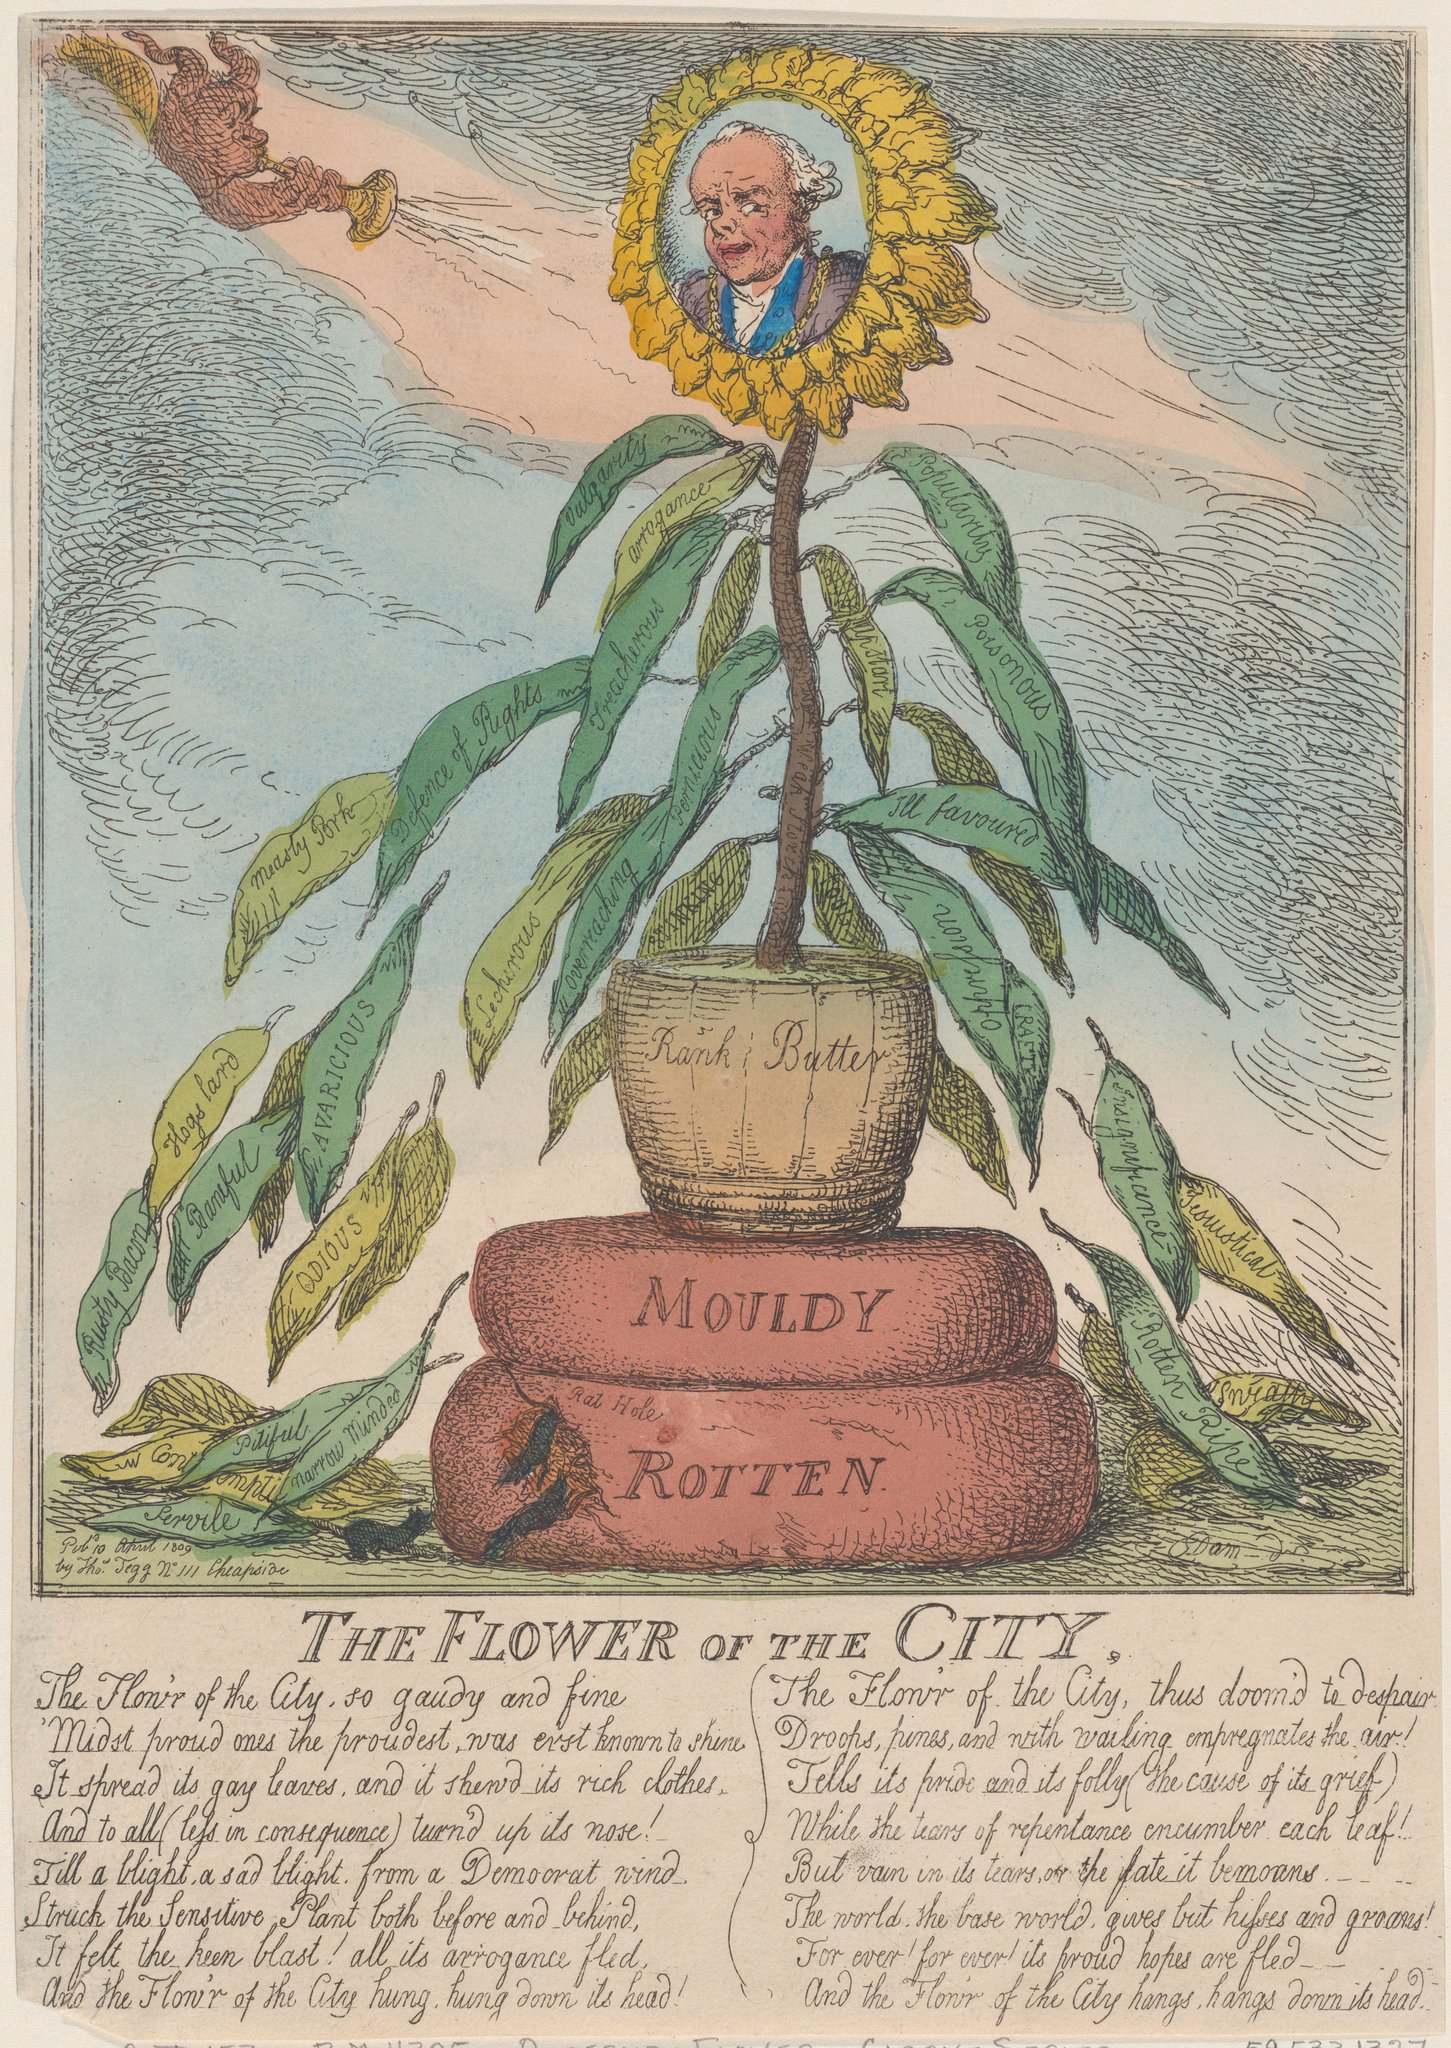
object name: print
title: The Flower of the City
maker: thomas rowlandson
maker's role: artist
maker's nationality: british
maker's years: 1757-1827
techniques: etching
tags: satire,politics